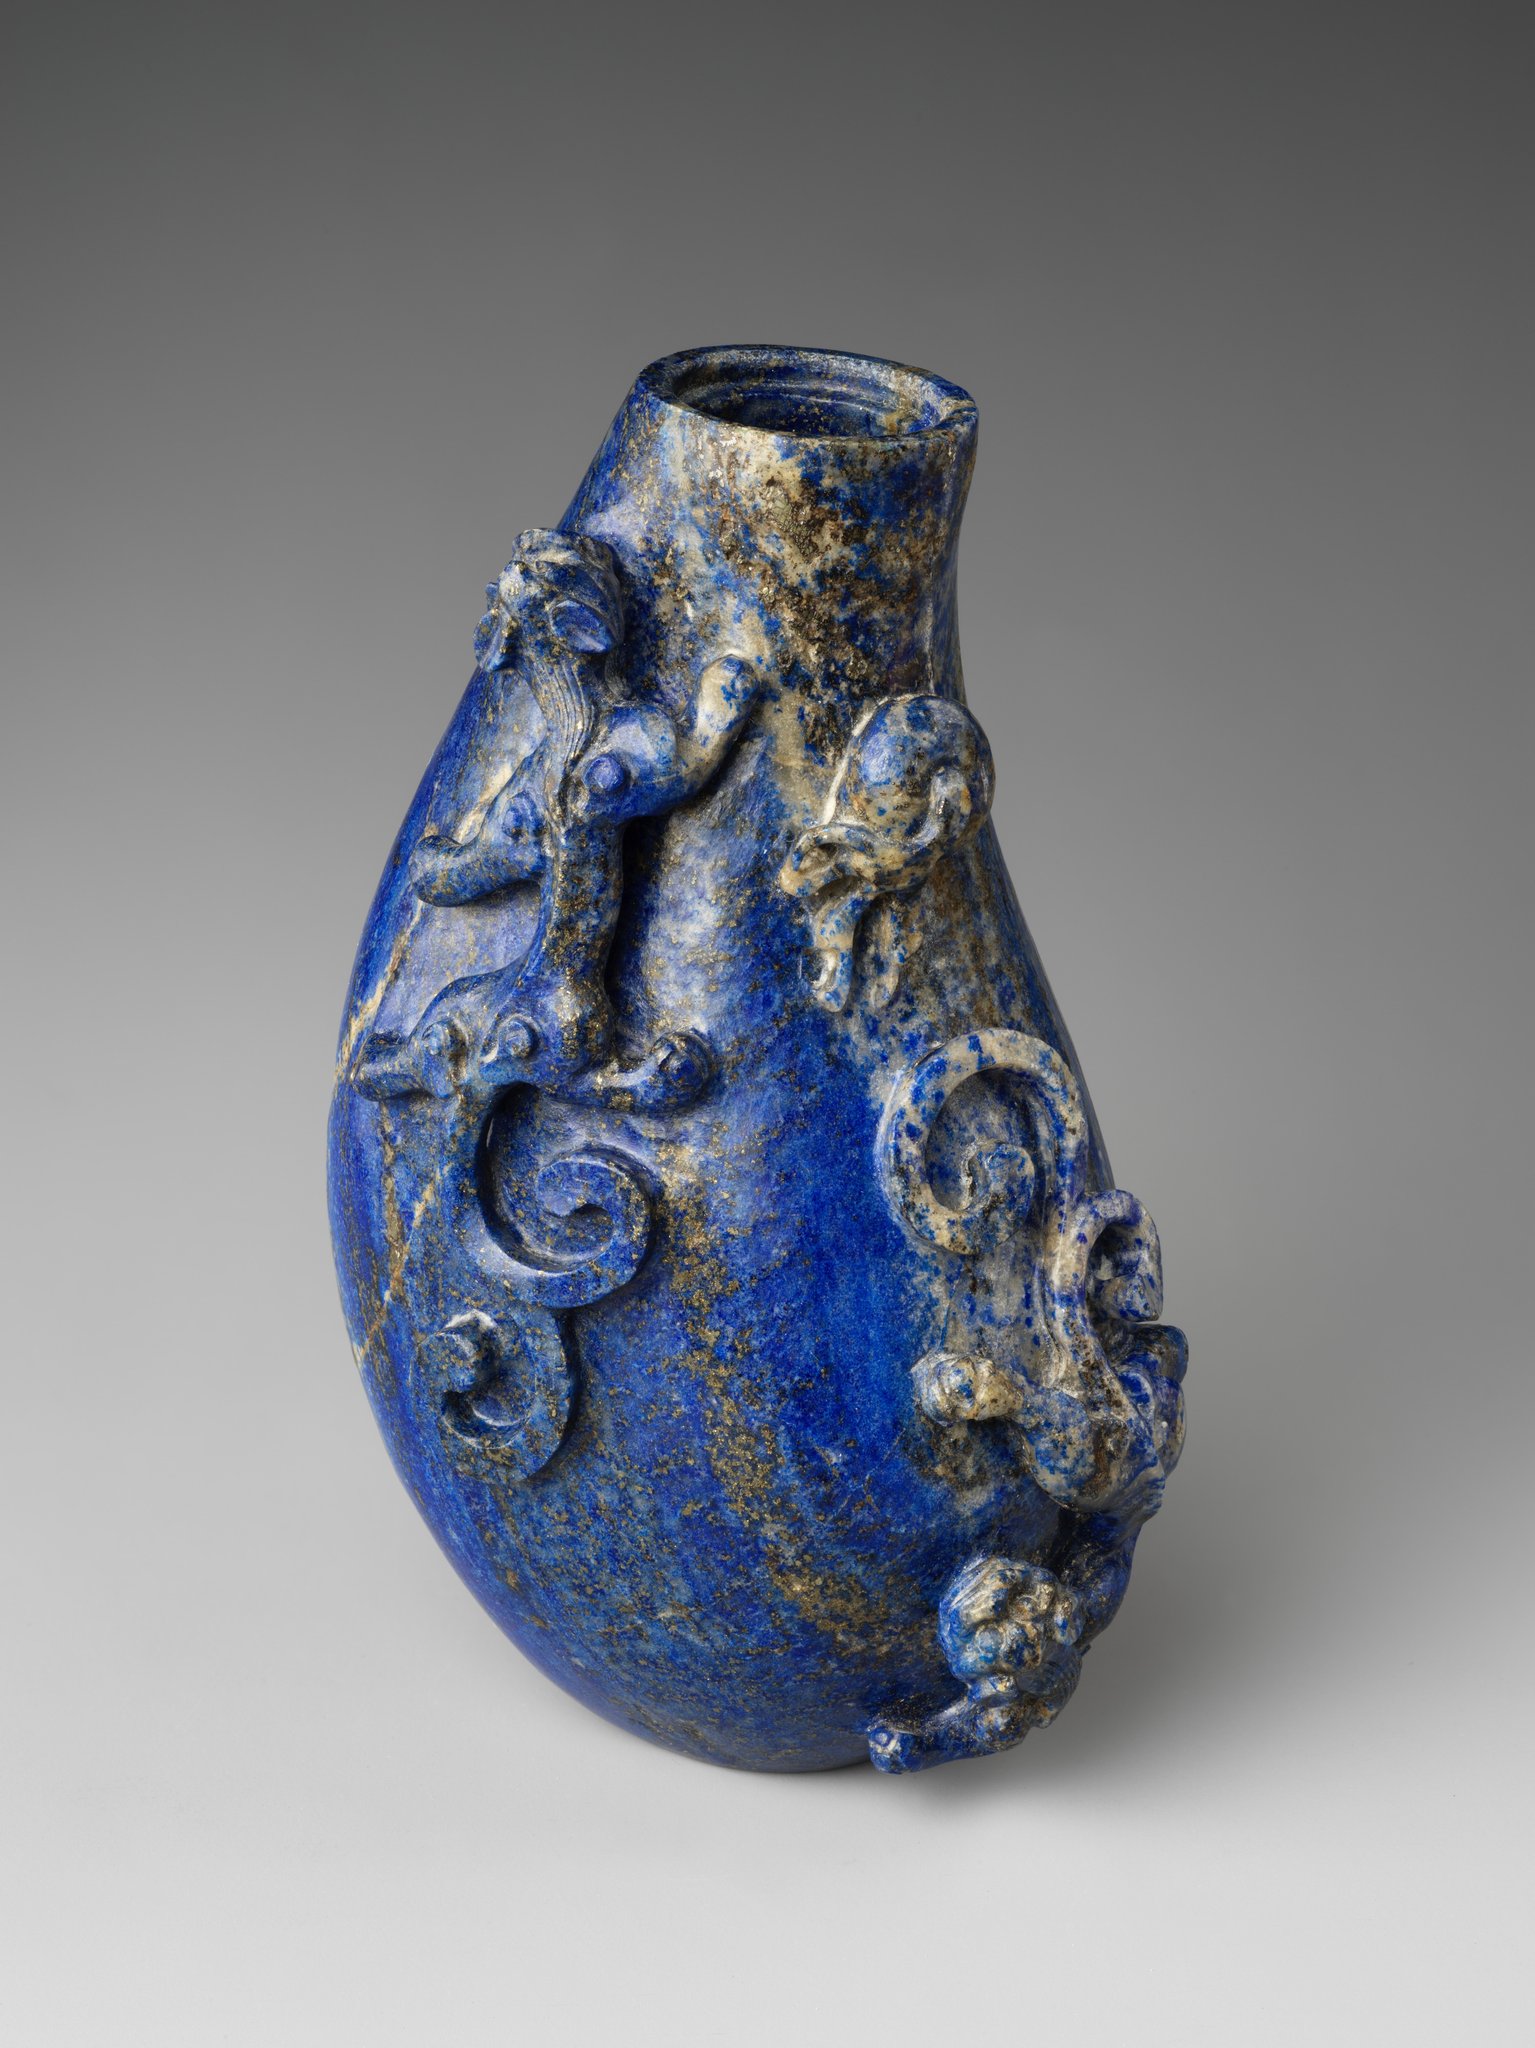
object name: bottle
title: Gourd-shaped bottle with chi dragons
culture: chinese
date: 1701-1800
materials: lapis lazuli